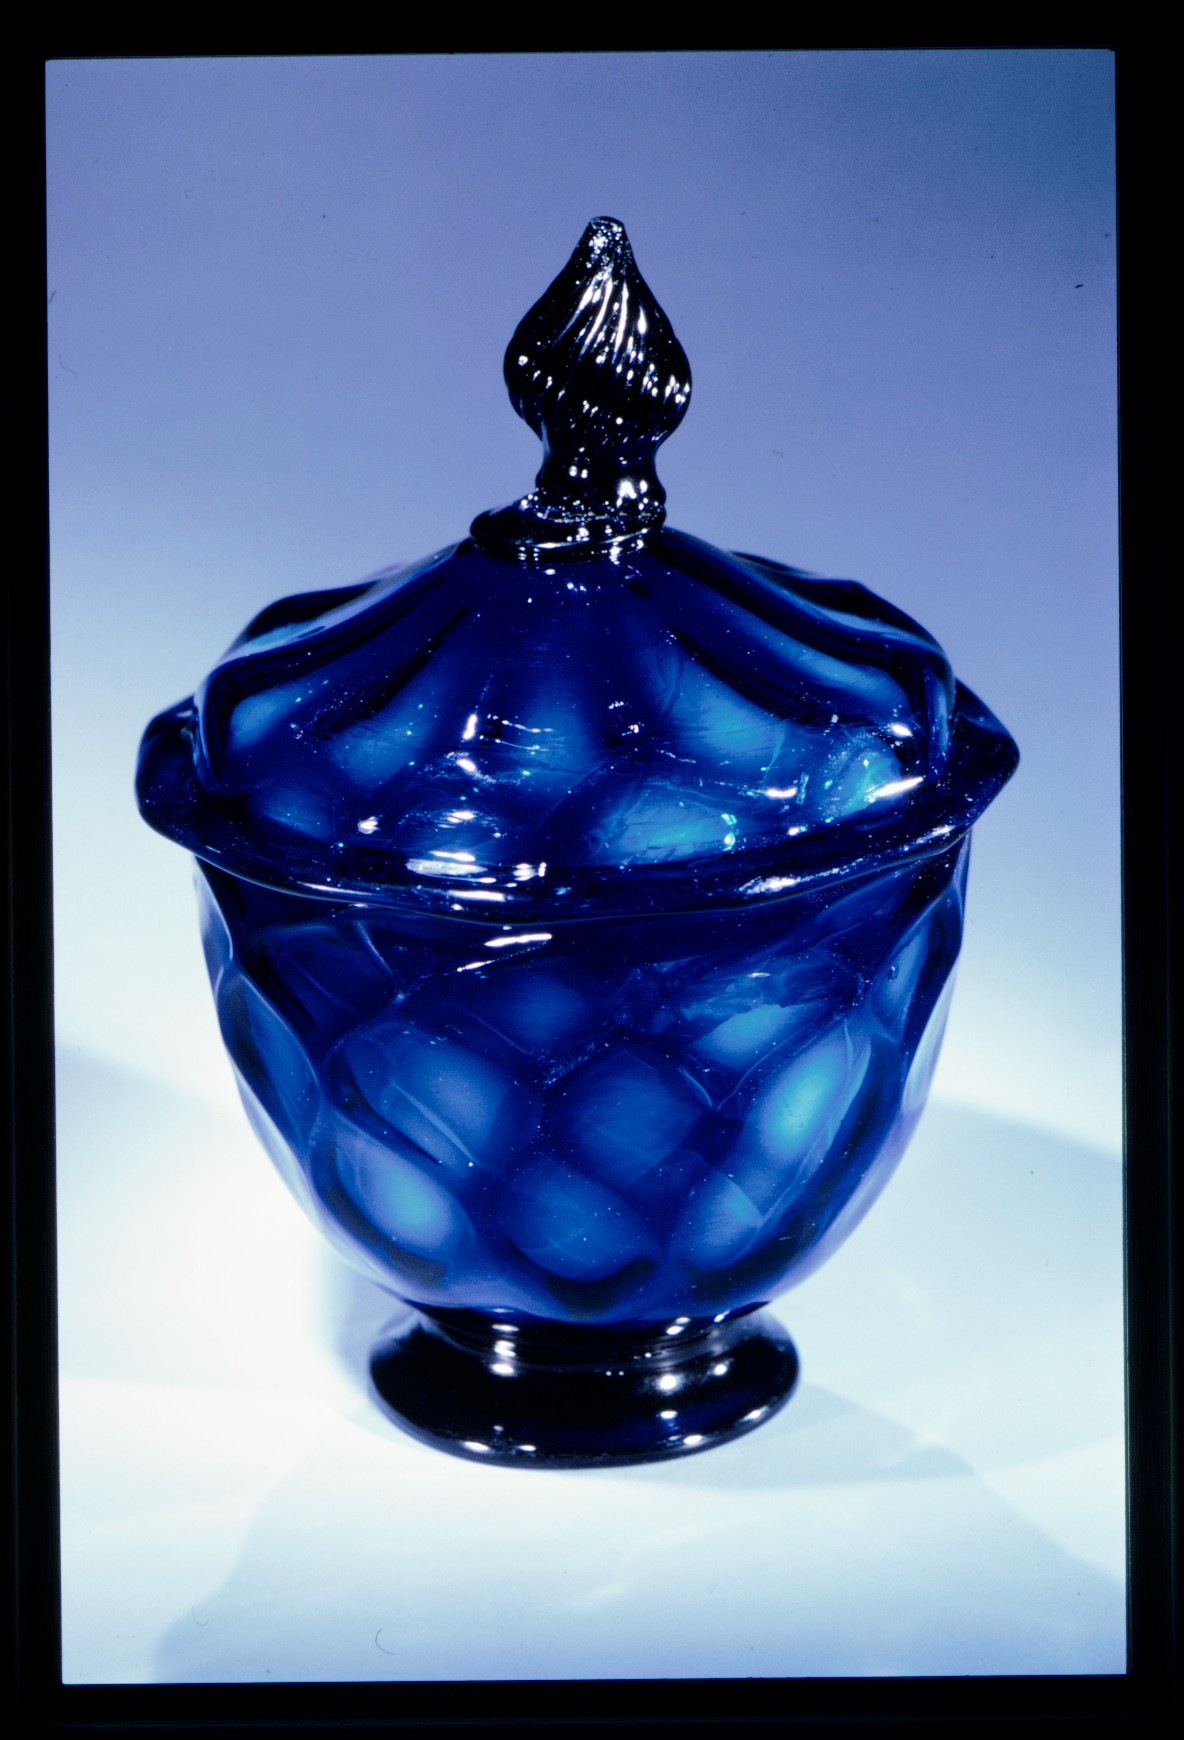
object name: sugar bowl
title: Covered Sugar Bowl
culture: american or british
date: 1780-1820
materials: glass, lead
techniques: glassblowing, molding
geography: england